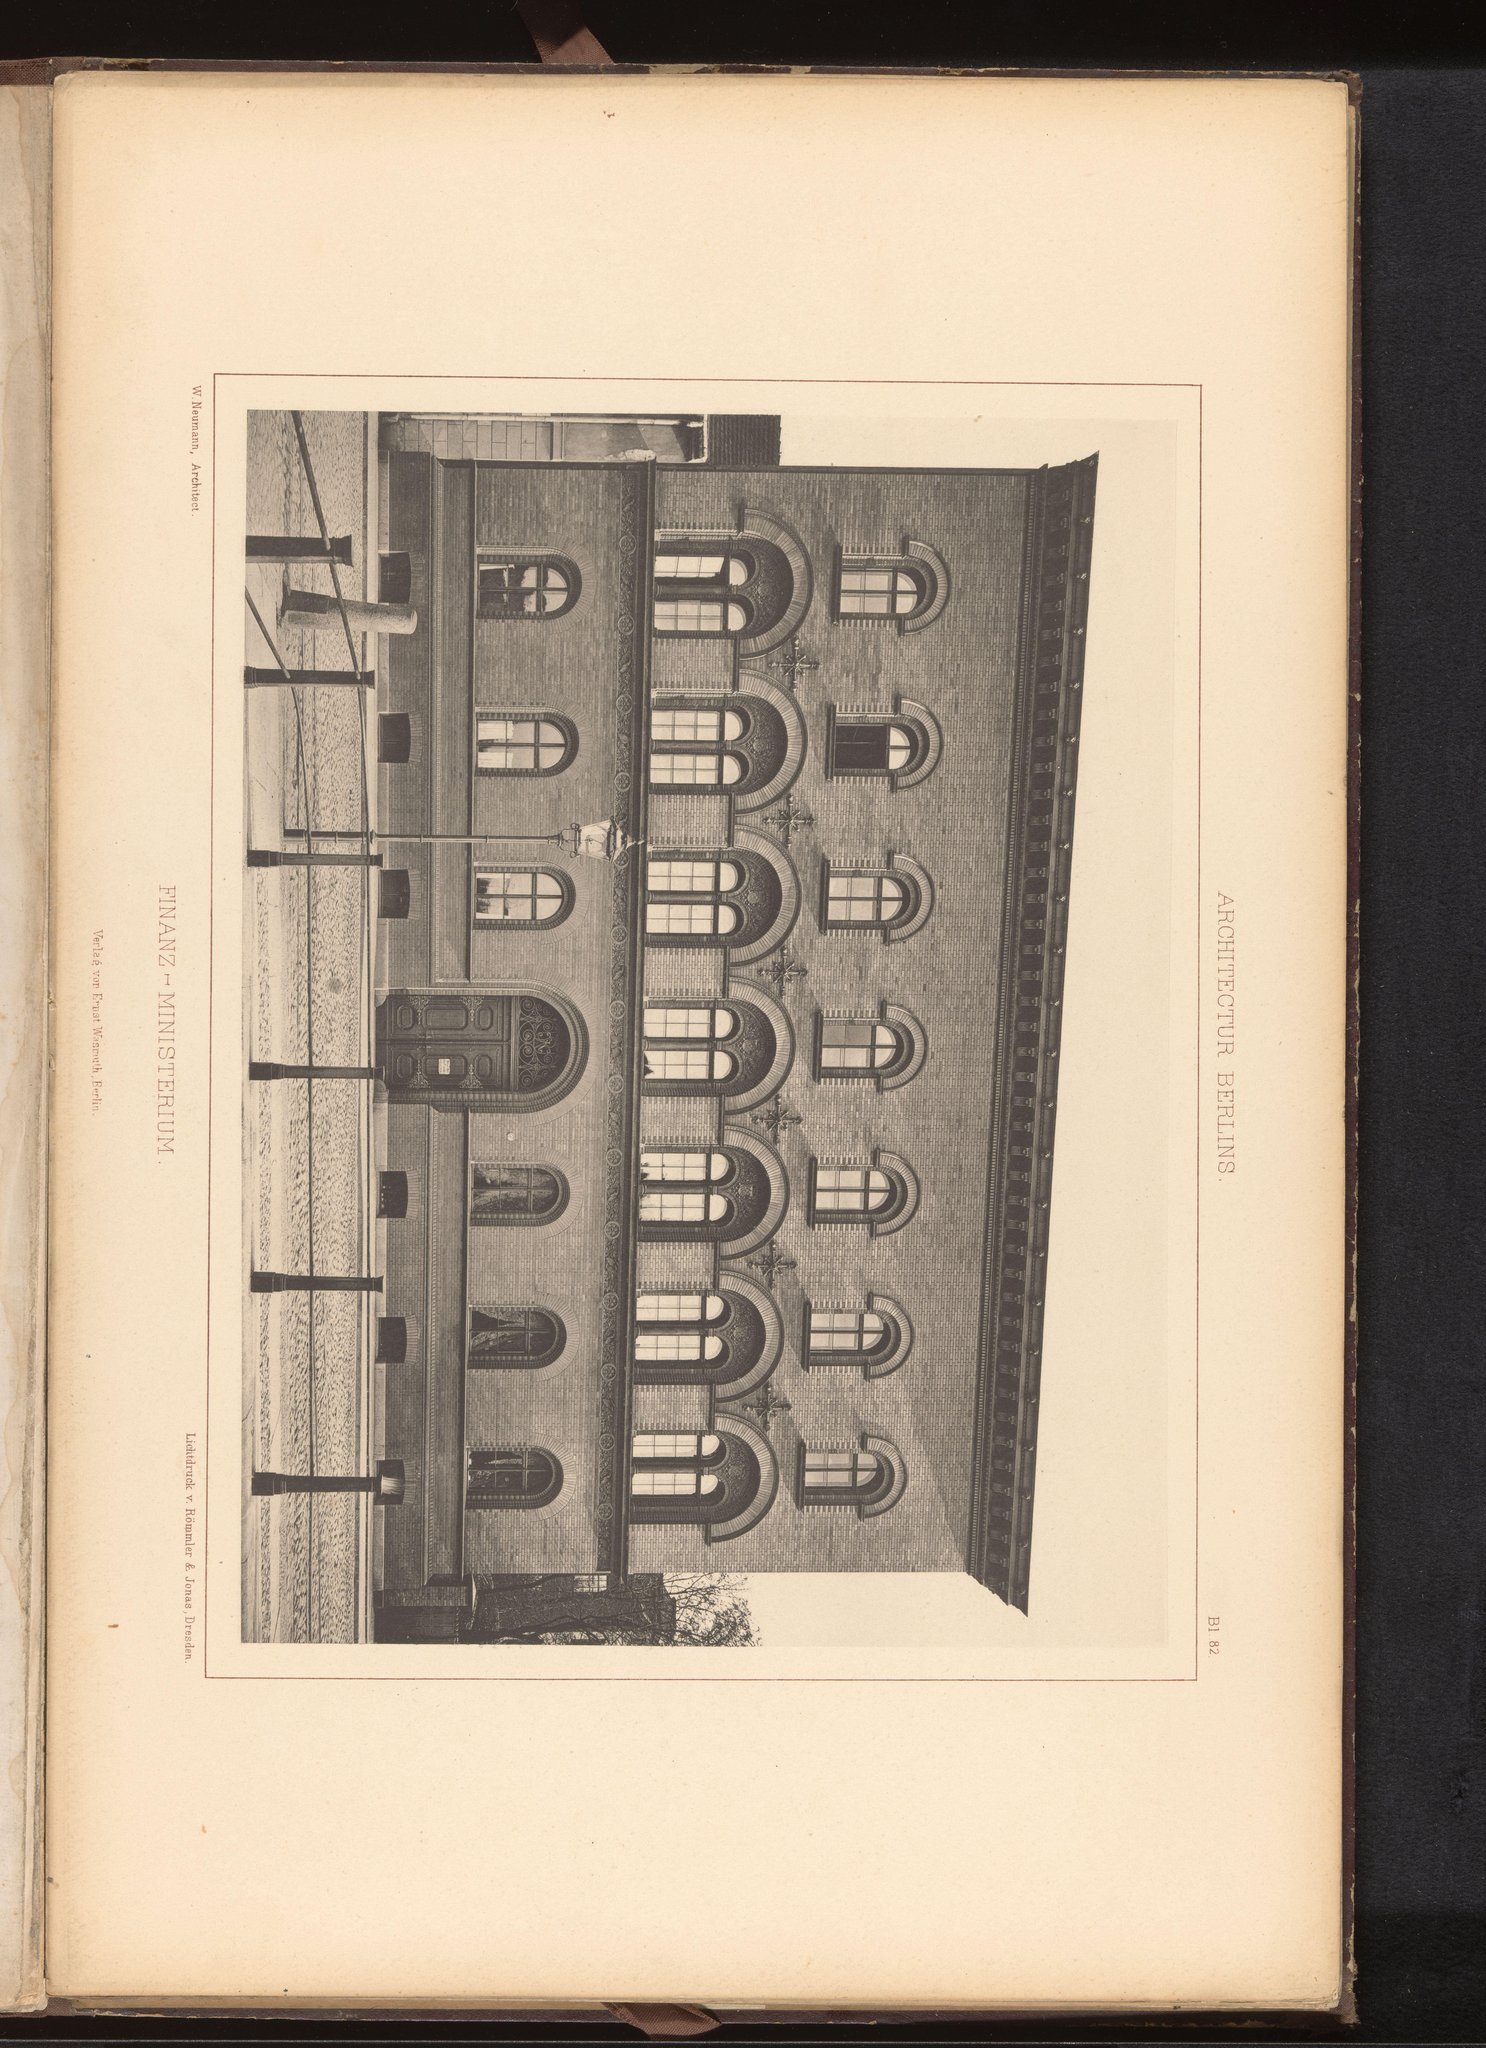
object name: photomechanical print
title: Finanz-Ministerium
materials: paper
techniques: photograph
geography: dresden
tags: national government, berlin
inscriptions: number: ‘Bl. 82.’, inscription: ‘W. Neumann, Architect.’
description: Deze prent maakt deel uit van een omslag met honderd prenten en zes tekstbladen.